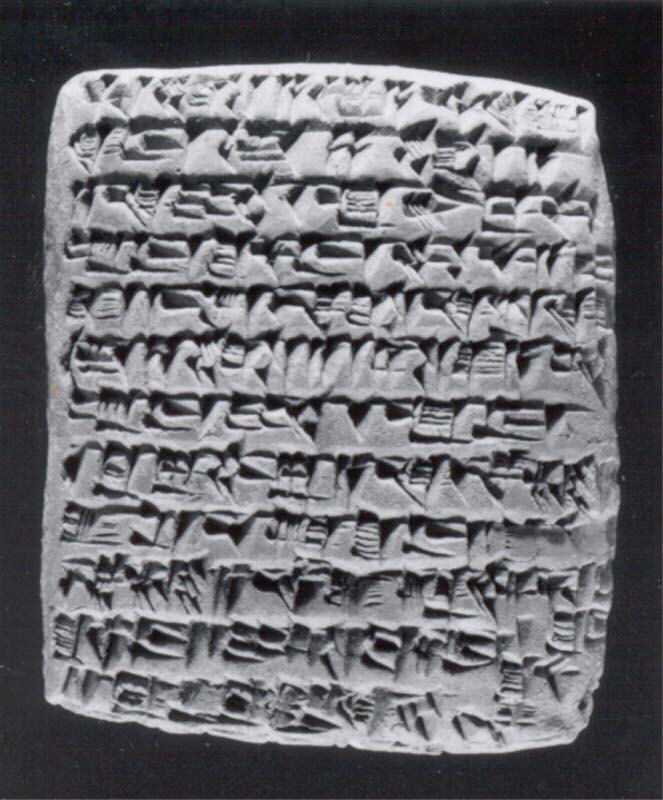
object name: cuneiform tablet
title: Cuneiform tablet: statement before witnesses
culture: assyrian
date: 2000-1801 BCE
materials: clay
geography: anatolia